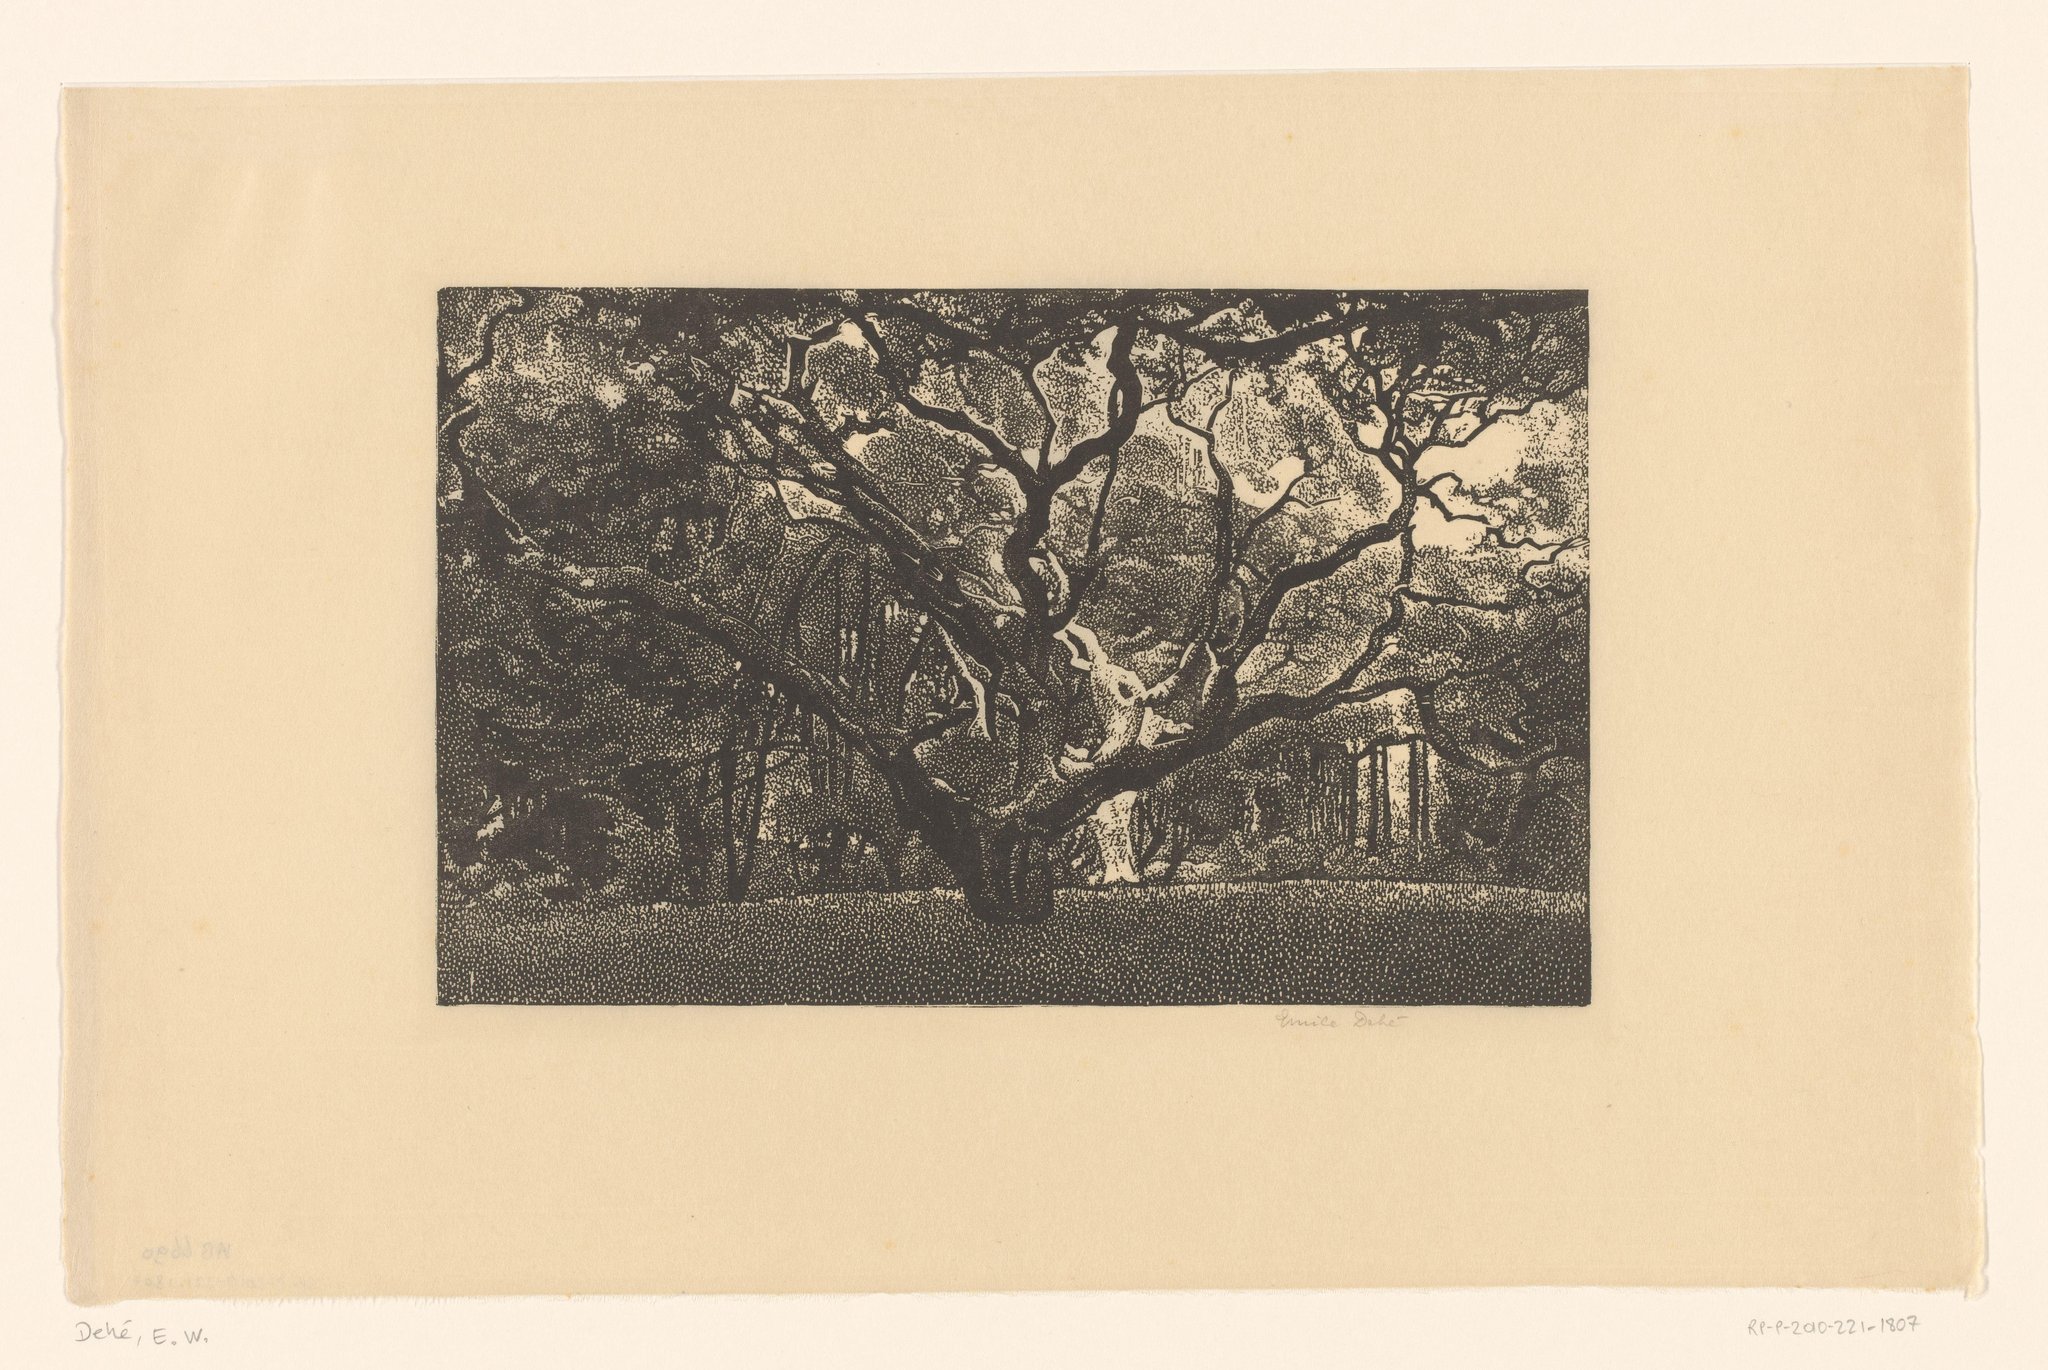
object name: print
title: Oude boom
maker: emilius wilhelmus dehé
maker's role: draughtsman, print maker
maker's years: 1886-1947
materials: paper, ink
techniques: lithograph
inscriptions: signature: ‘Emile Dehé’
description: Gezicht op een oude boom tussen andere bomen.